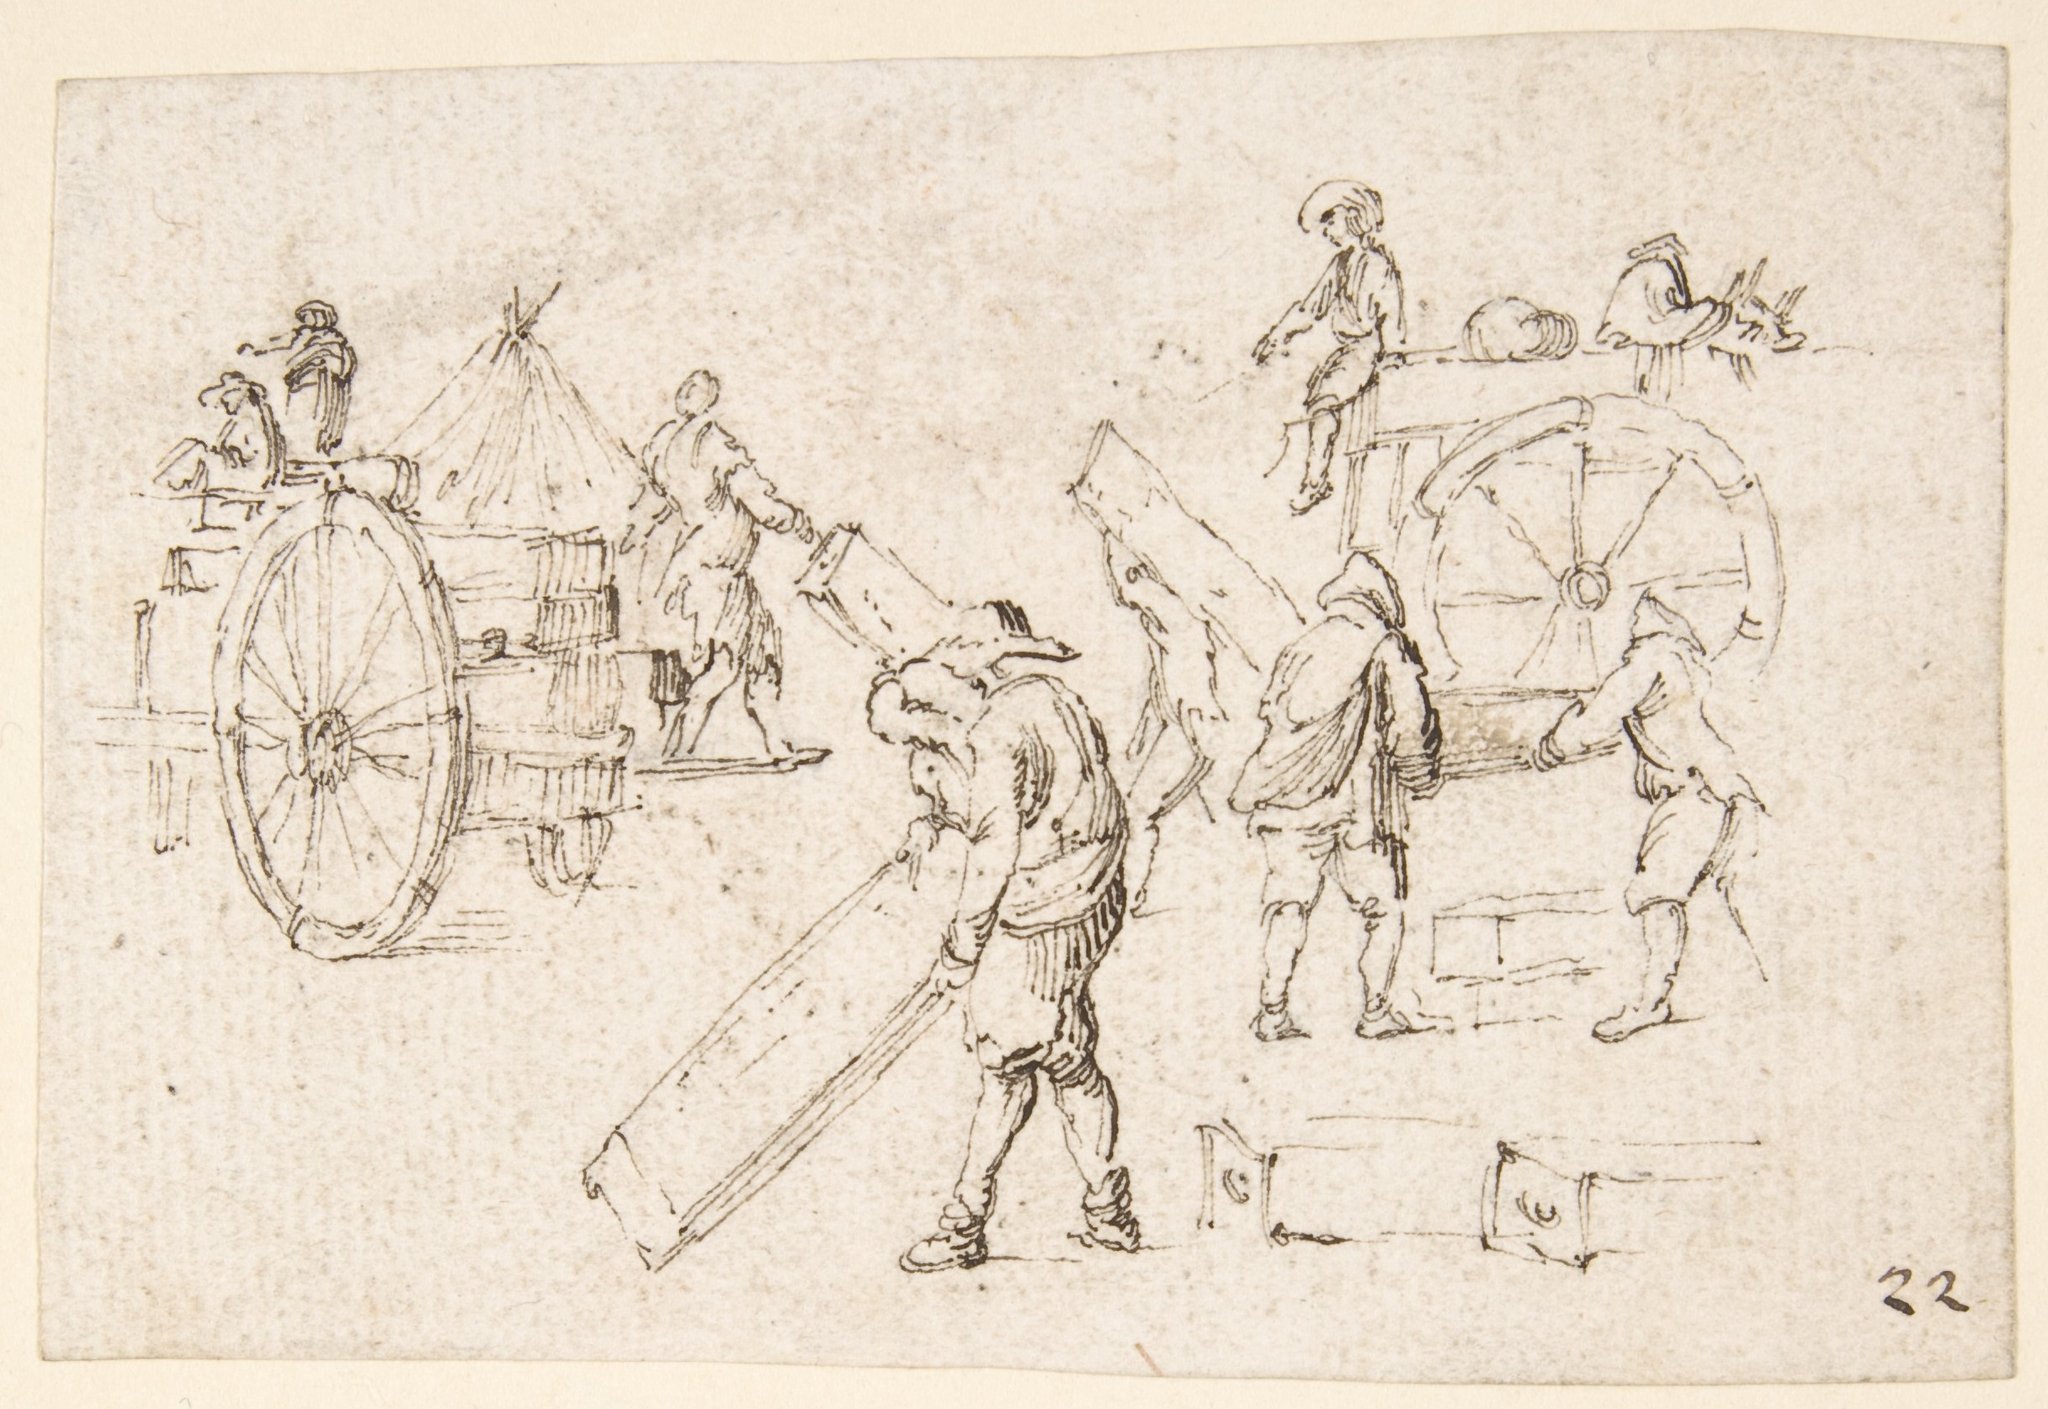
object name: drawing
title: Men Loading Wagons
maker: stefano della bella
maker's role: artist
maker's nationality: italian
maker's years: 1610-1664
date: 1610-1664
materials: ink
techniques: pen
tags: men,working